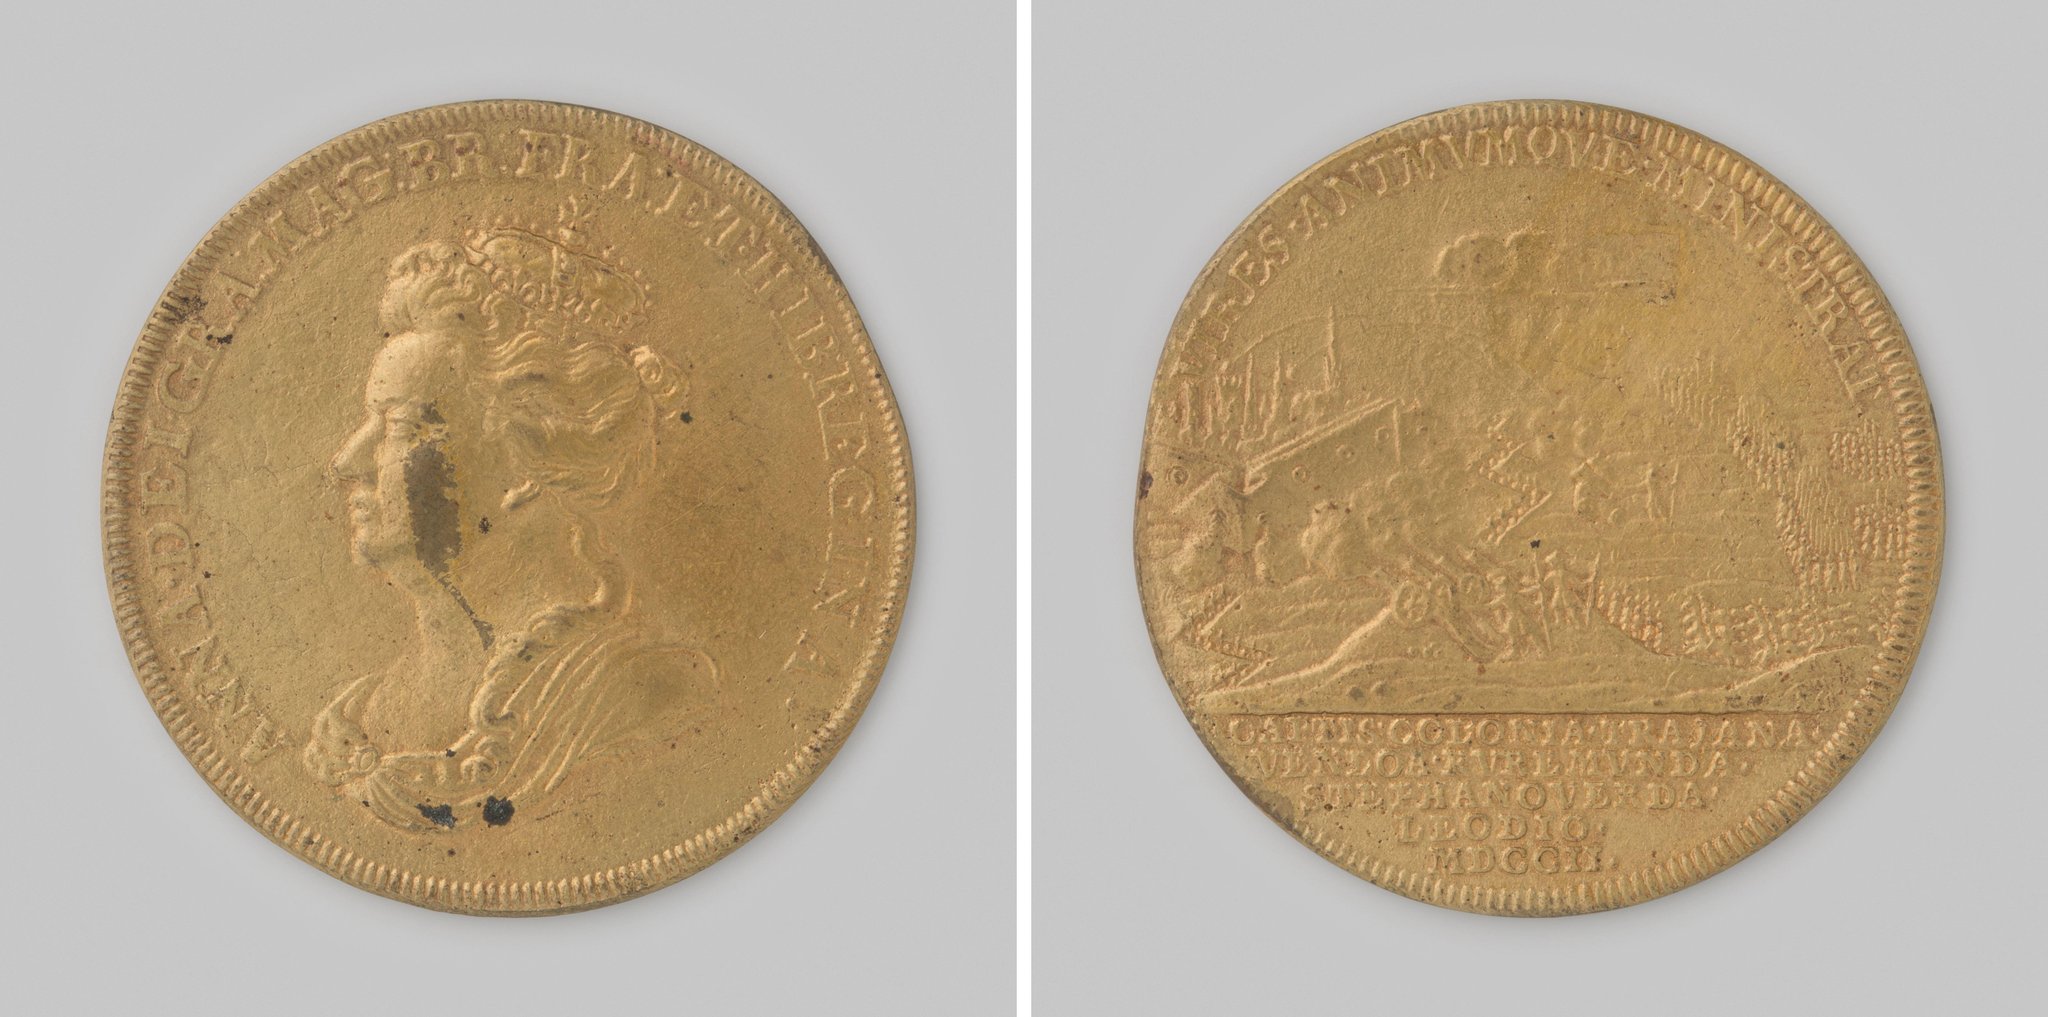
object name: history medal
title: Inname van Kaiserswerth, Venlo, Roermond, Stevensweerd en Luik door de geallieerden op Frankrijk 1702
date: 1702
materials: brass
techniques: casting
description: Verguld messing penning, op de voorzijde het portret van Koningin Anna van Engeland naar links met omschrift, op de keerzijde de beschieting van Luik, met omschrift en afsnedetekst.